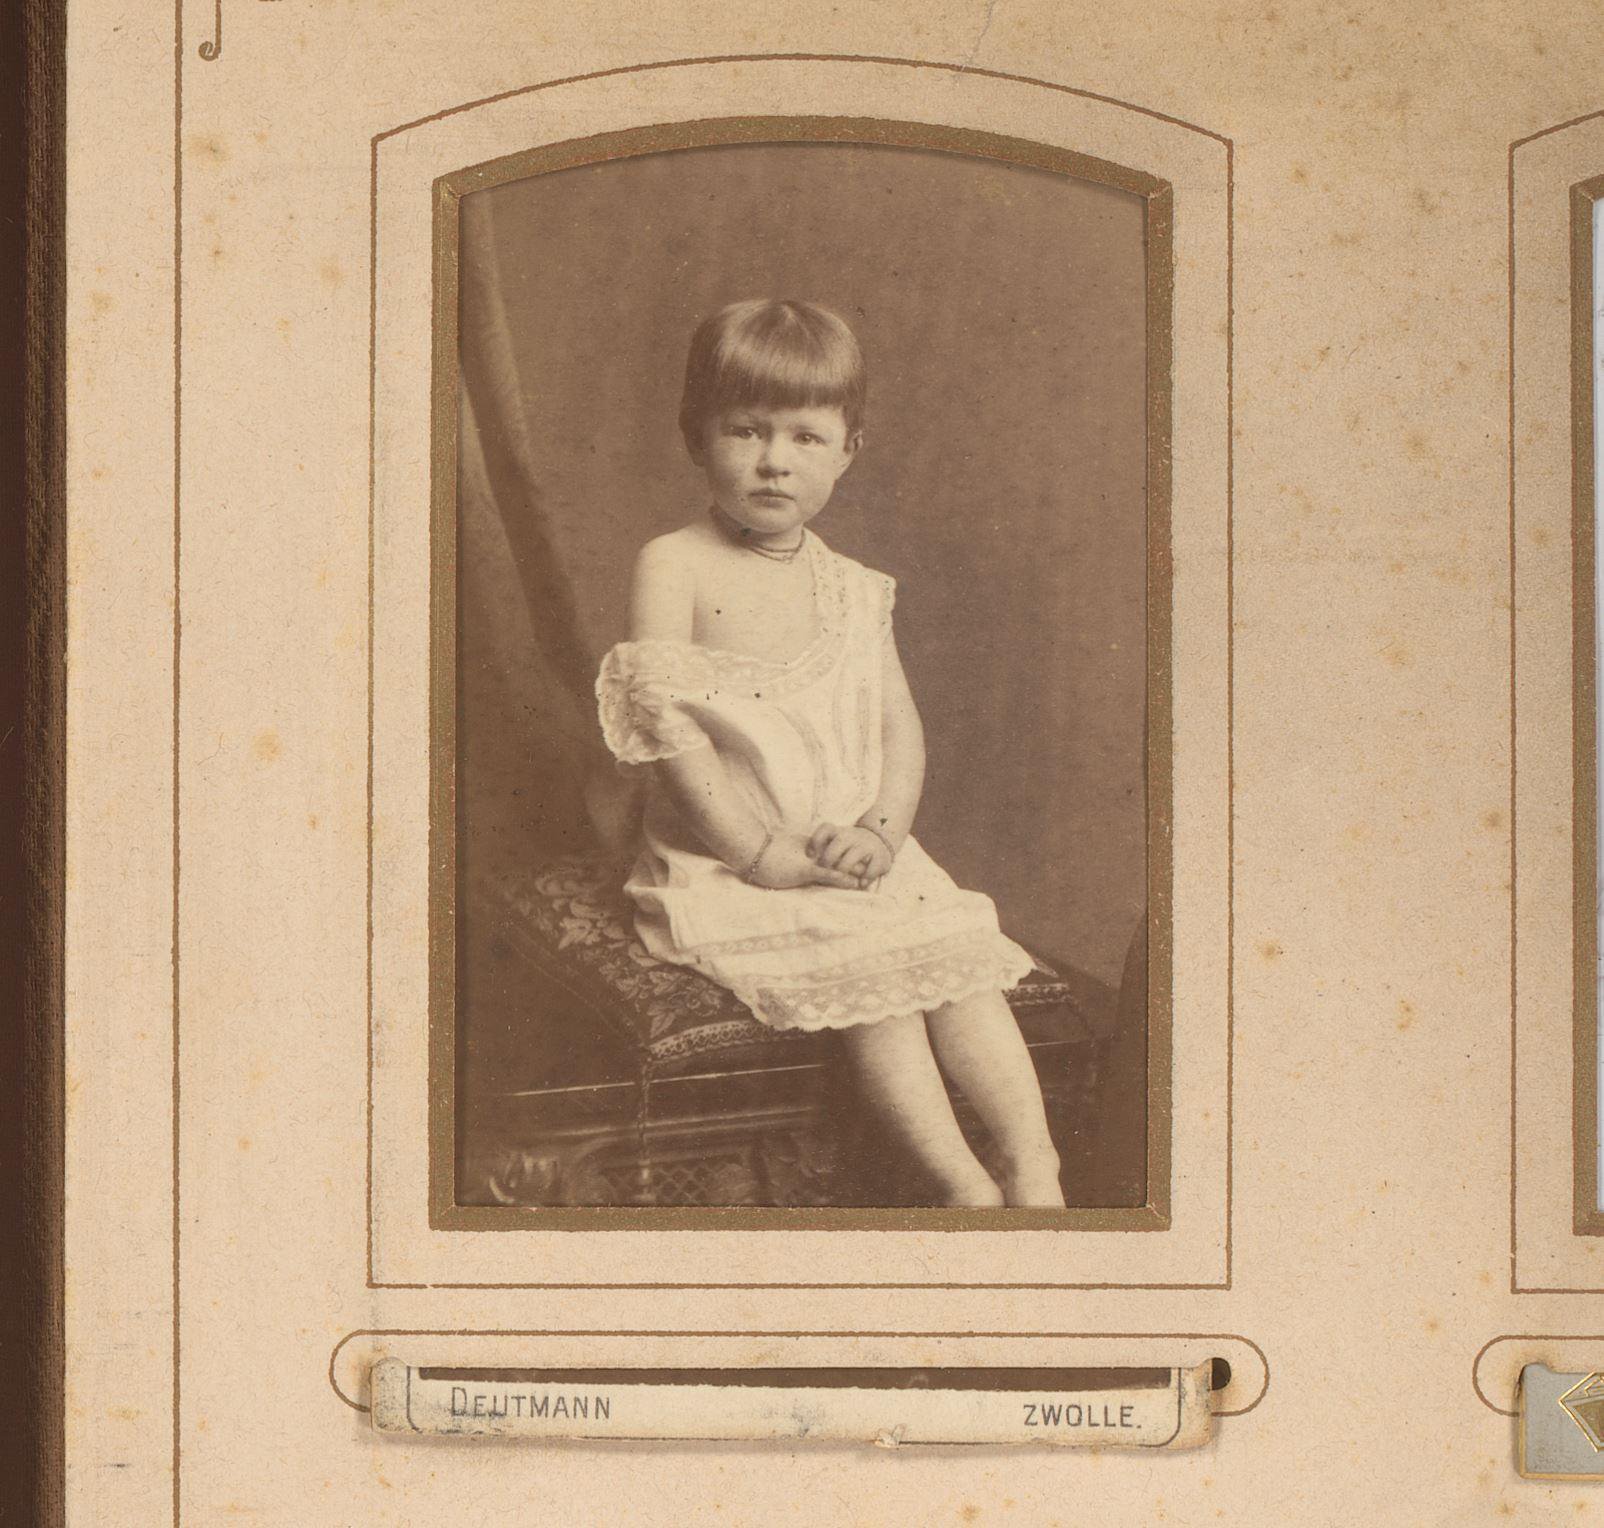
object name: carte de visite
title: Portret van een zittend meisje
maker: franz wilhelm heinrich deutmann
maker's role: fotograaf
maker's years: 1840-1906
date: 1865-1900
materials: cardboard, photographic support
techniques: albumen print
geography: zwolle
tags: sitting figure - aa - female human figure, girl (child between toddler and youth)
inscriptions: inscription: ‘Deutmann/ Zwolle’